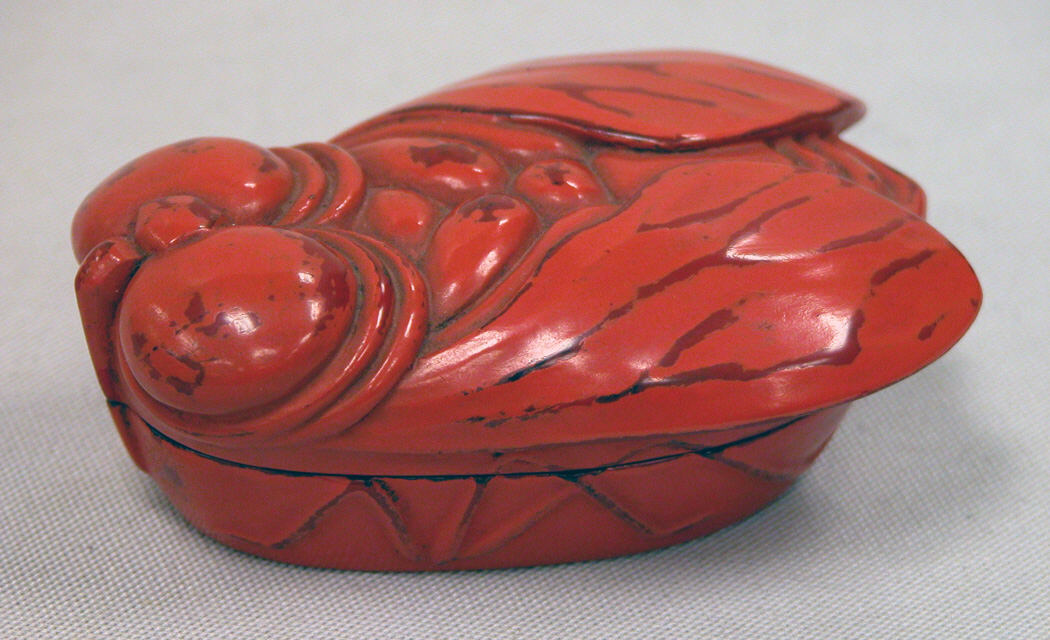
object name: incense burner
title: Incense Burner in Shape of Cicada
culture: japanese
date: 1867-1900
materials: lacquer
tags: insects